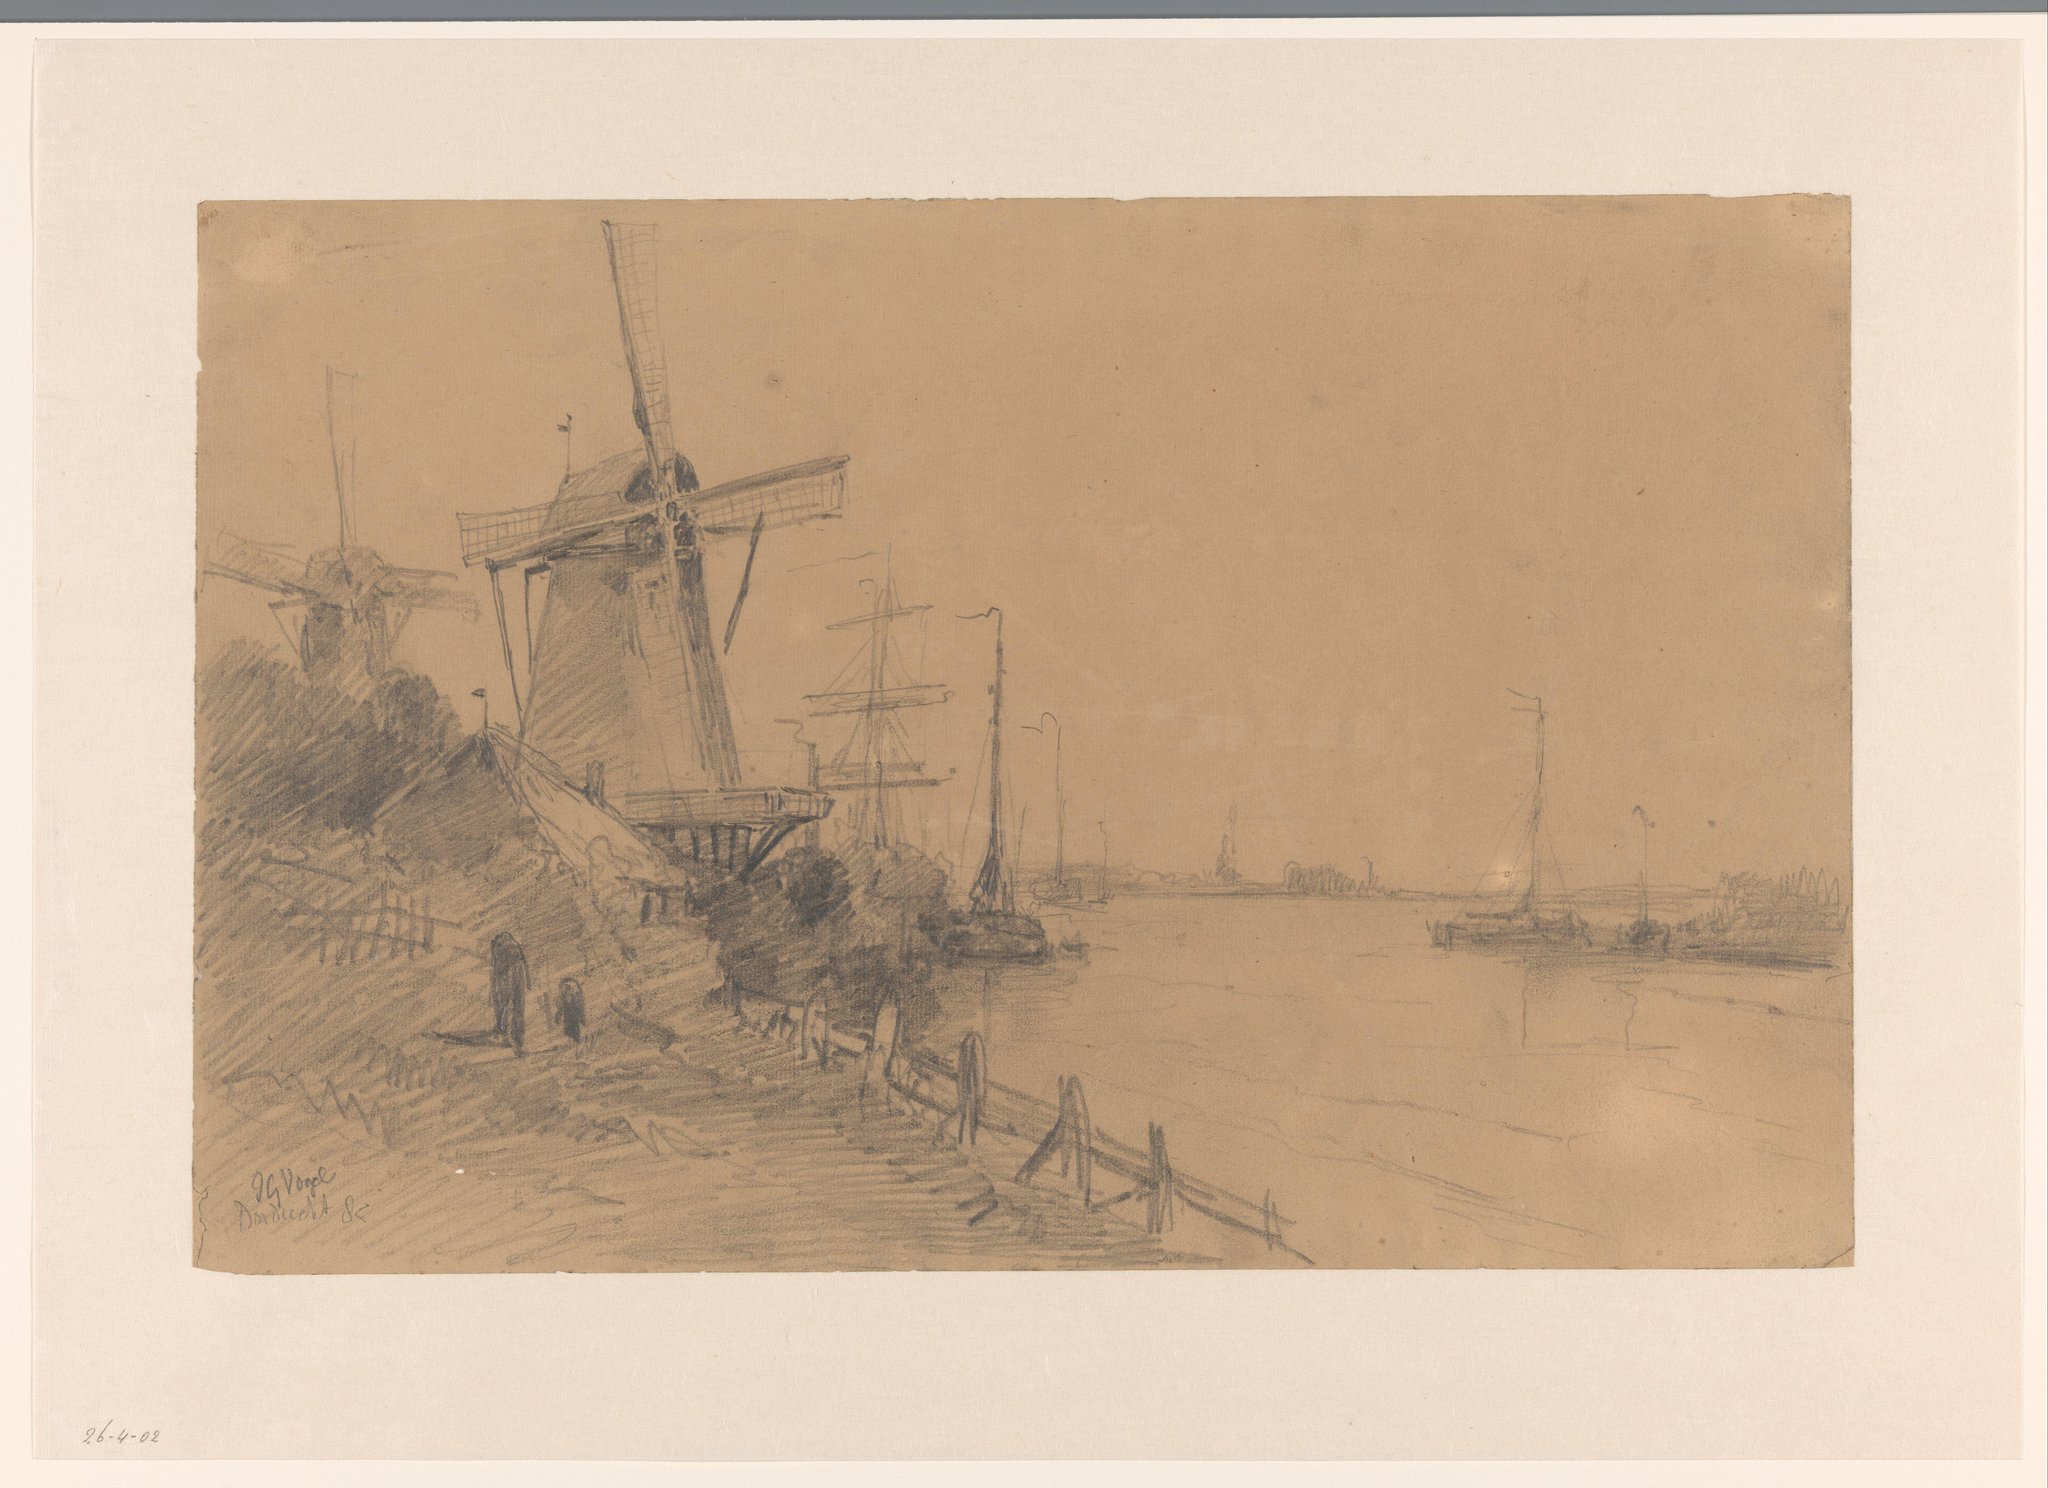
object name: drawing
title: Molens bij Dordrecht langs de rivier met schepen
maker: johannes gijsbert vogel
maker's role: draughtsman, painter, print maker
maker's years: 1828-1915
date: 1885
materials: chalk, paper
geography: dordrecht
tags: river, windmill, dordrecht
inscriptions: date